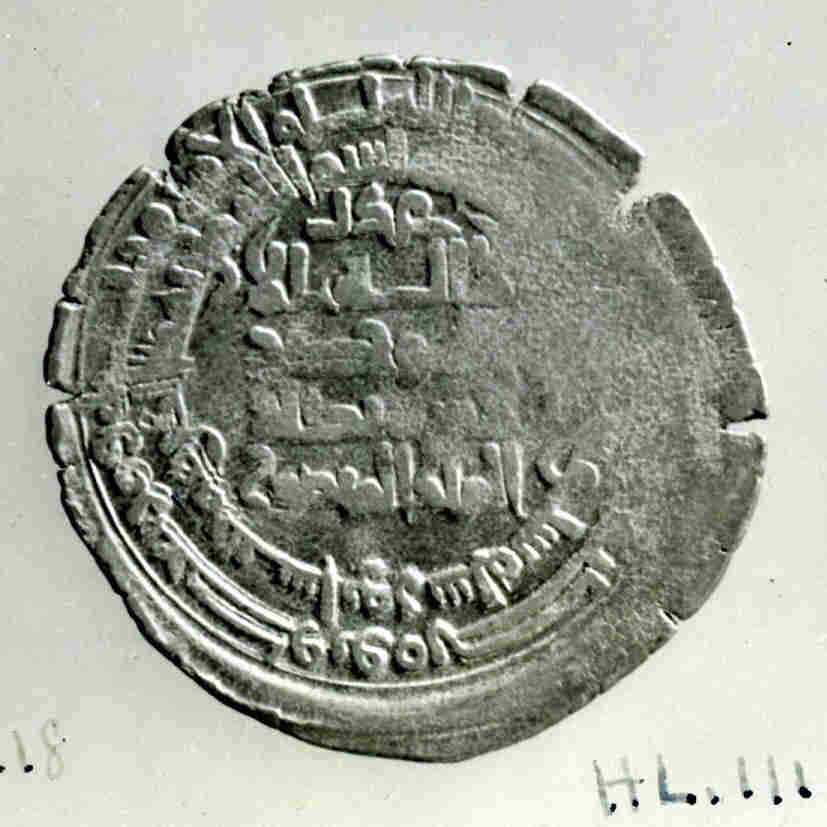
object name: coin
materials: silver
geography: iran